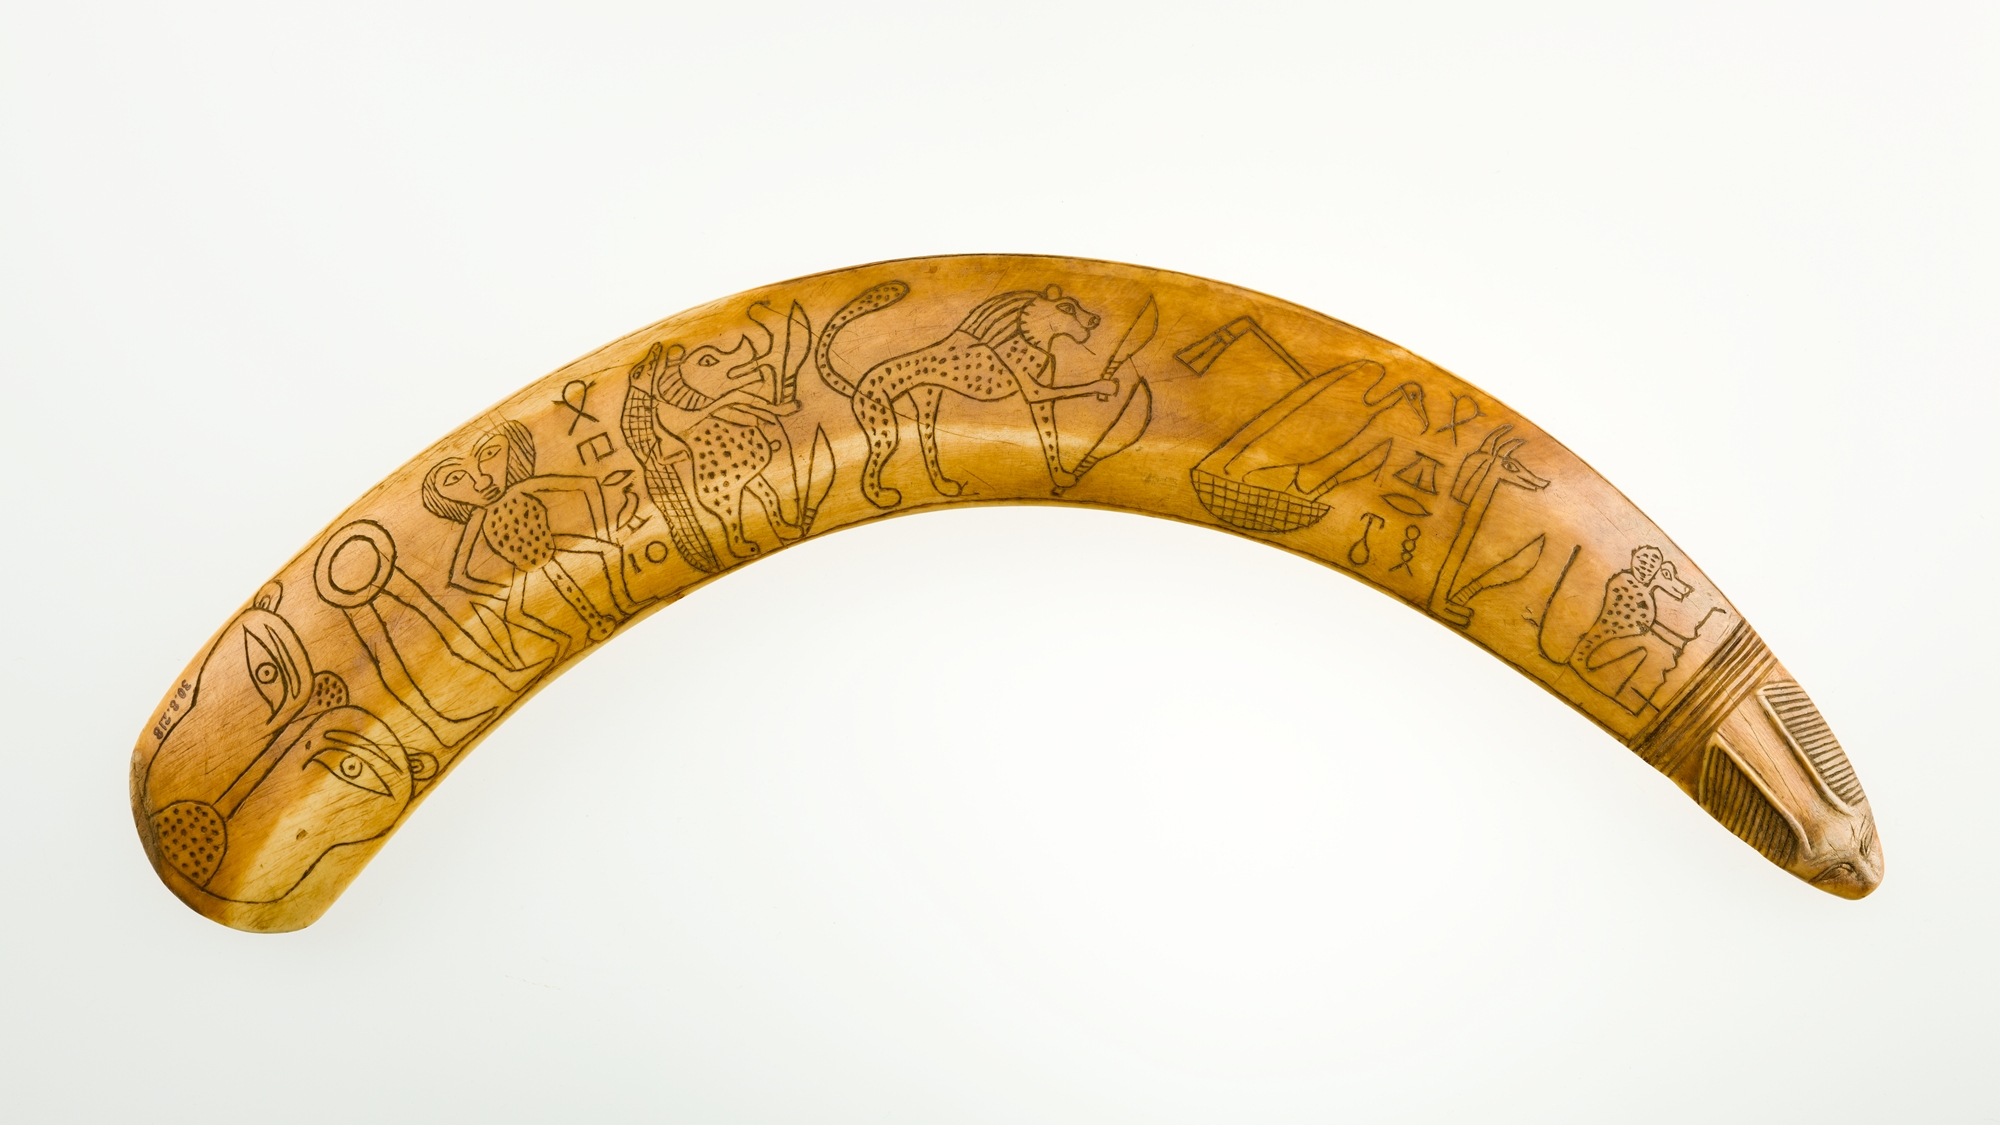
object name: magic wand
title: Apotropaic Wand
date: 1981-1640 BCE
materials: ivory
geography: egypt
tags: animals